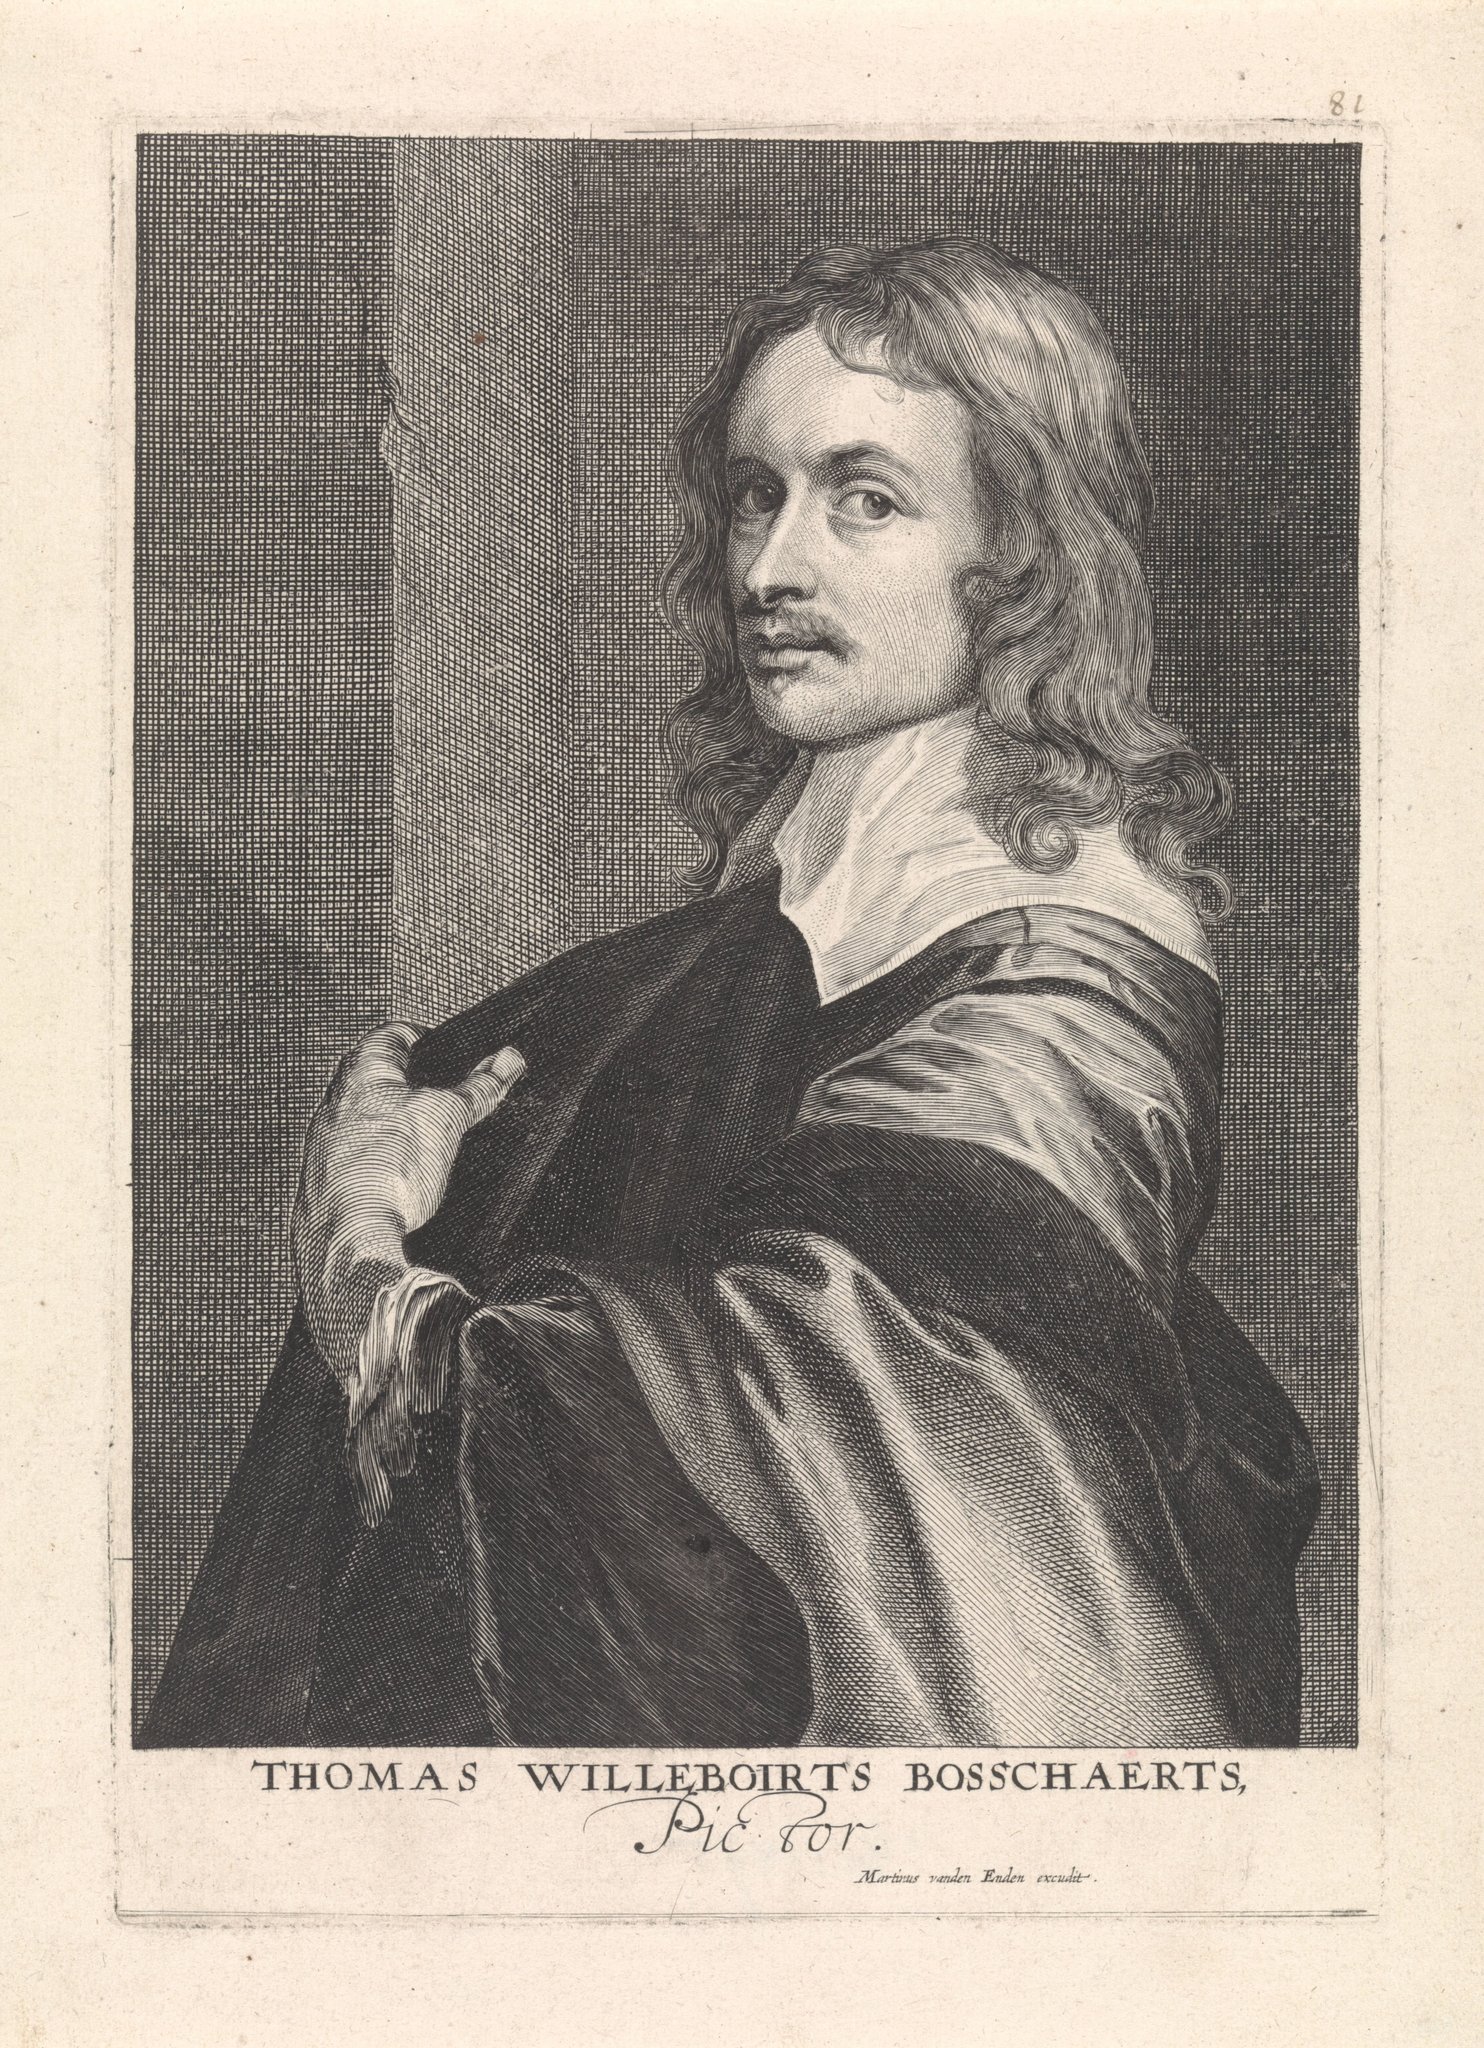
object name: print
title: Portret van Thomas Willeboirts Bosschaerts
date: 1630-1660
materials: paper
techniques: engraving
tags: antwerp, painter, draughtsman, thomas willeboirts bosschaert, portrait, self-portrait of painter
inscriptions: collector's mark: Lugt 2165, collector's mark: Lugt 2760, inscription: ‘81’, collector's mark: Lugt 2228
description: Portret ten halven lijven naar links van de kunstschilder Thomas Willeboirts Bosschaerts, met de linkerhand op de borst. Hij heeft lang haar, draagt een platte kraag en is in een mantel gehuld.